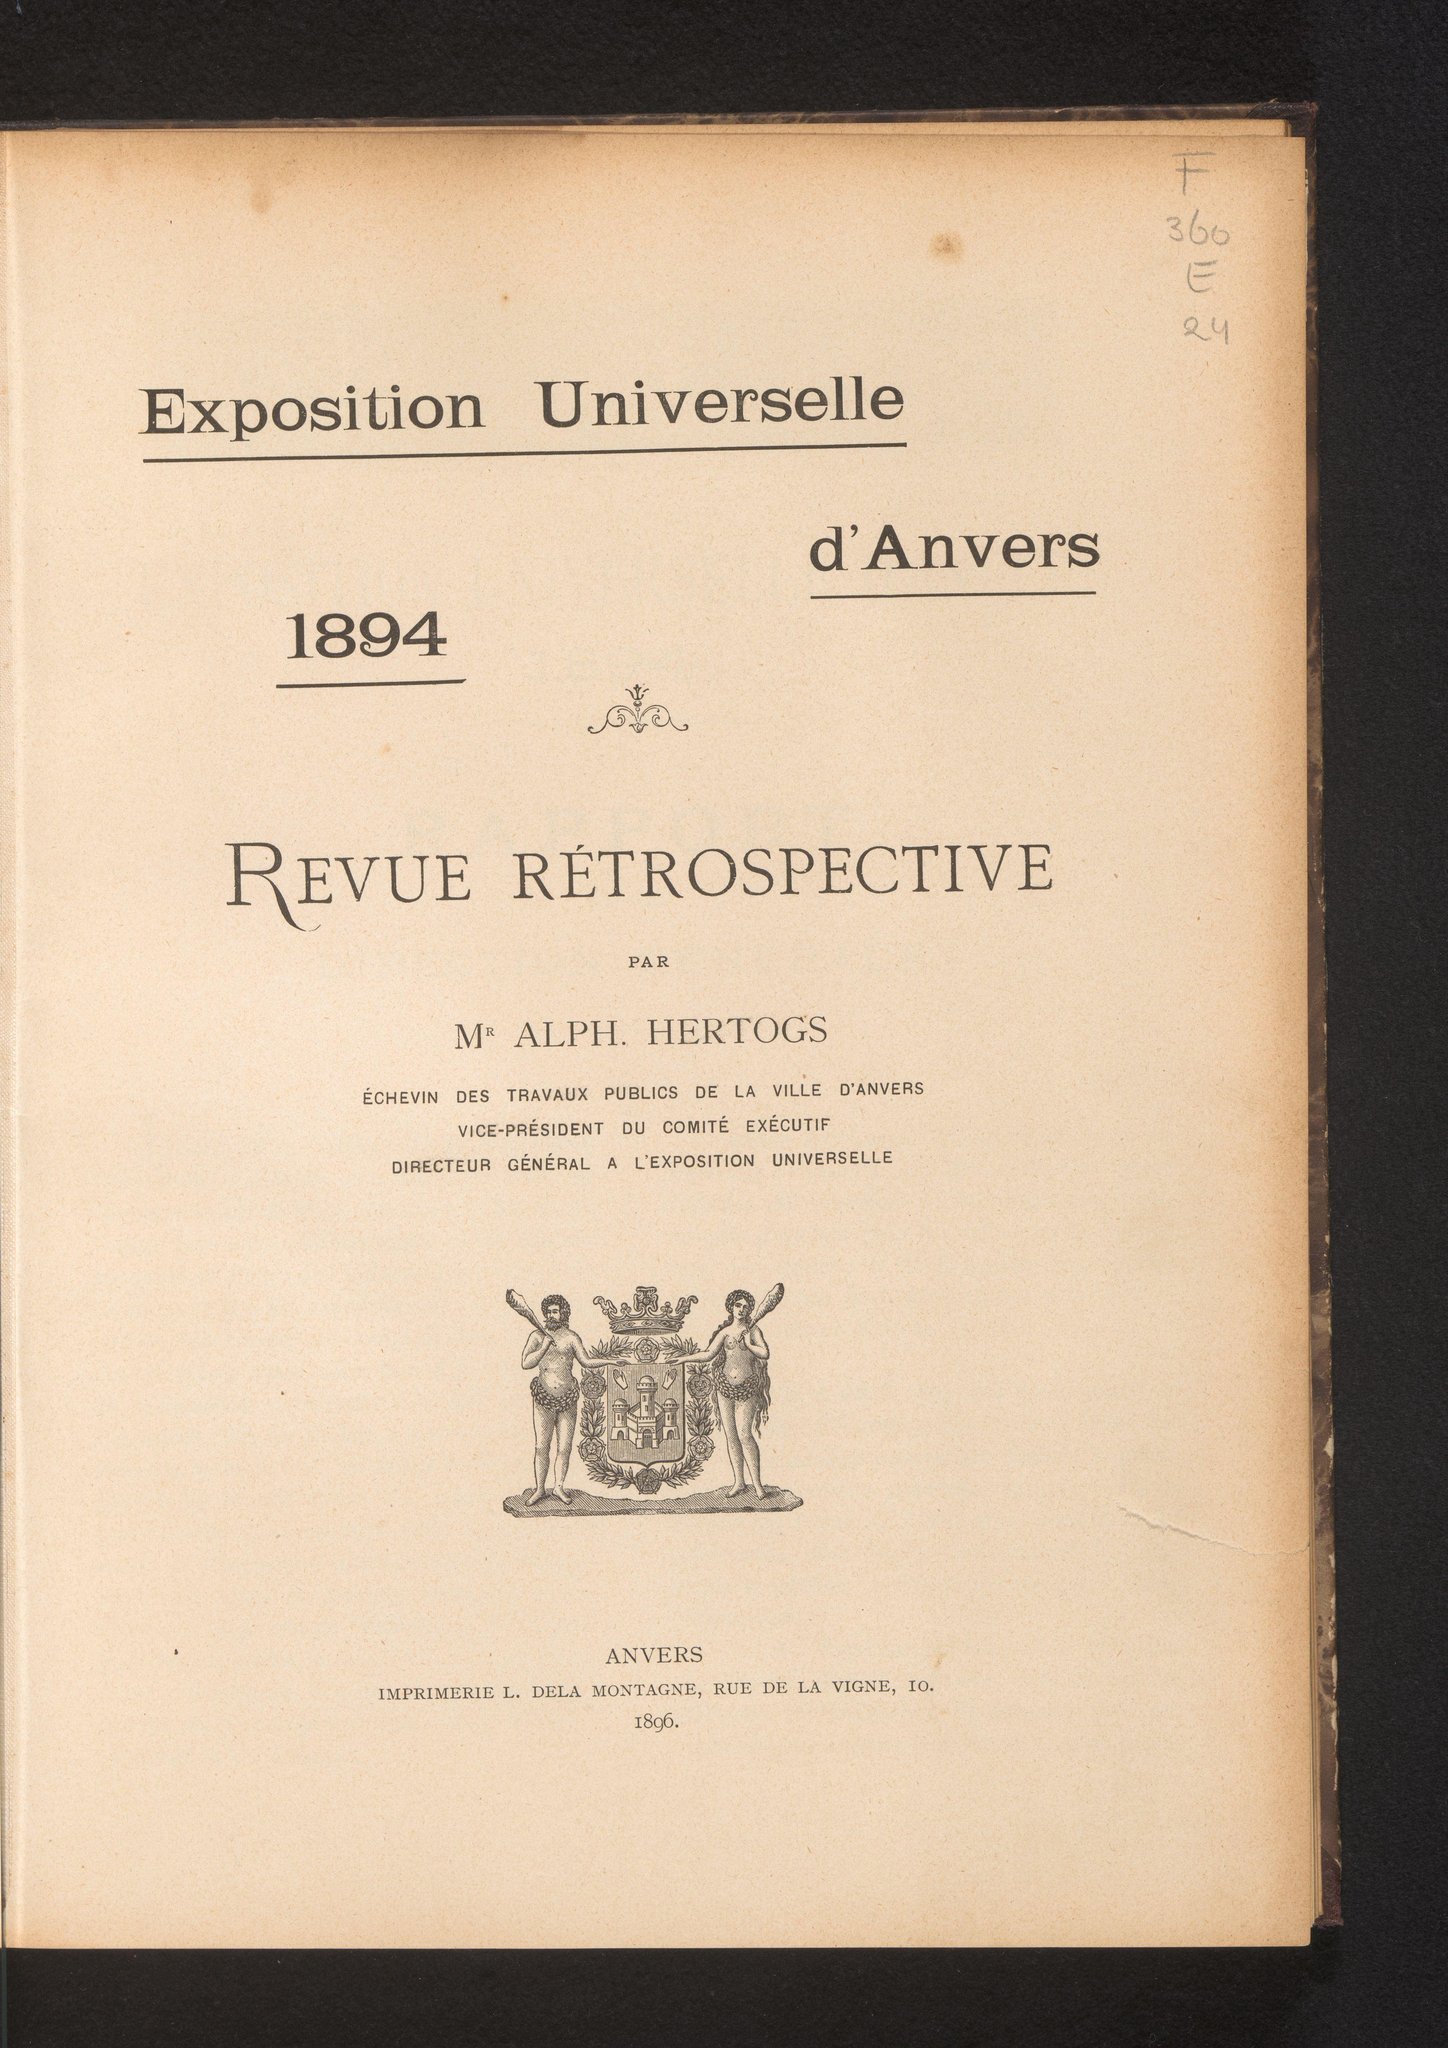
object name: book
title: Exposition universelle d'Anvers 1894: revue rétrospective / par Alph. Hertogs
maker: alphonse hertogs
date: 1896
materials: cardboard, linen, paper, photographic support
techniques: photograph, decorated paper, lithograph, printing, marbling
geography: antwerp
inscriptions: annotation: ‘R19/1/89 1800,-’, annotation: ‘MAY/ 1995’, bookplate: ‘FAMILIAE SJONGERS/ 1808/ ANTVERPIENSIS EX-LIBRIS’